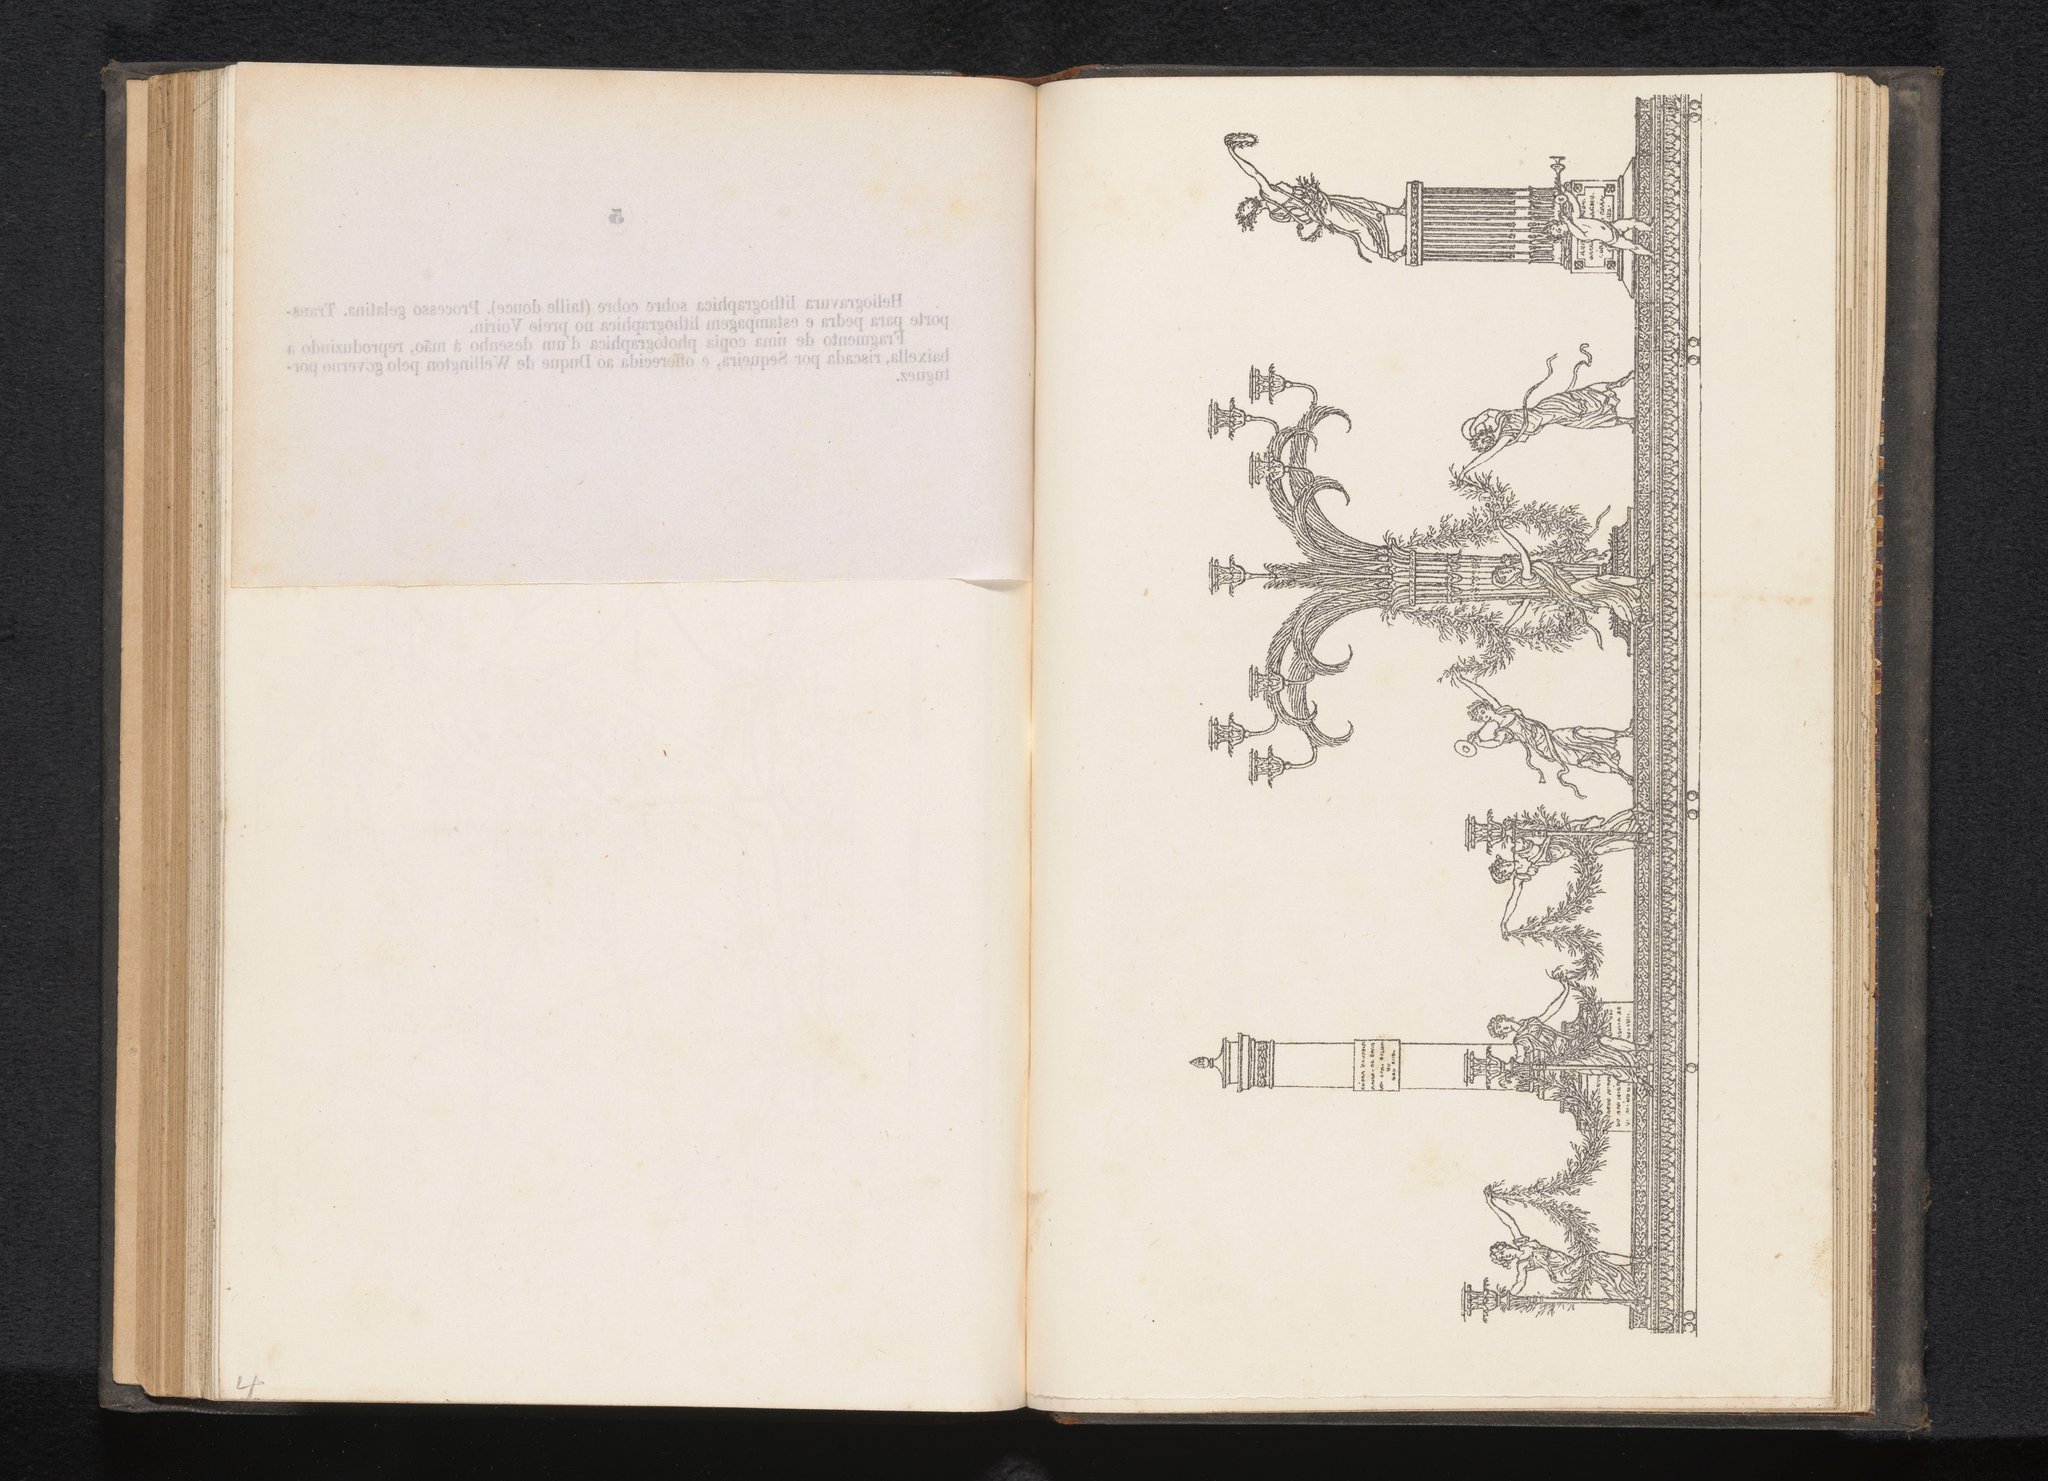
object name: reproduction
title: Fotoreproductie van een prent, voorstellende een dansend gezelschap rond straatlantaarns en sculpturale ornamenten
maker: Anonymous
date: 1866-1876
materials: paper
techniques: photoaquatint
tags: lantern, group dancing, sculpture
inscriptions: number: ‘5’